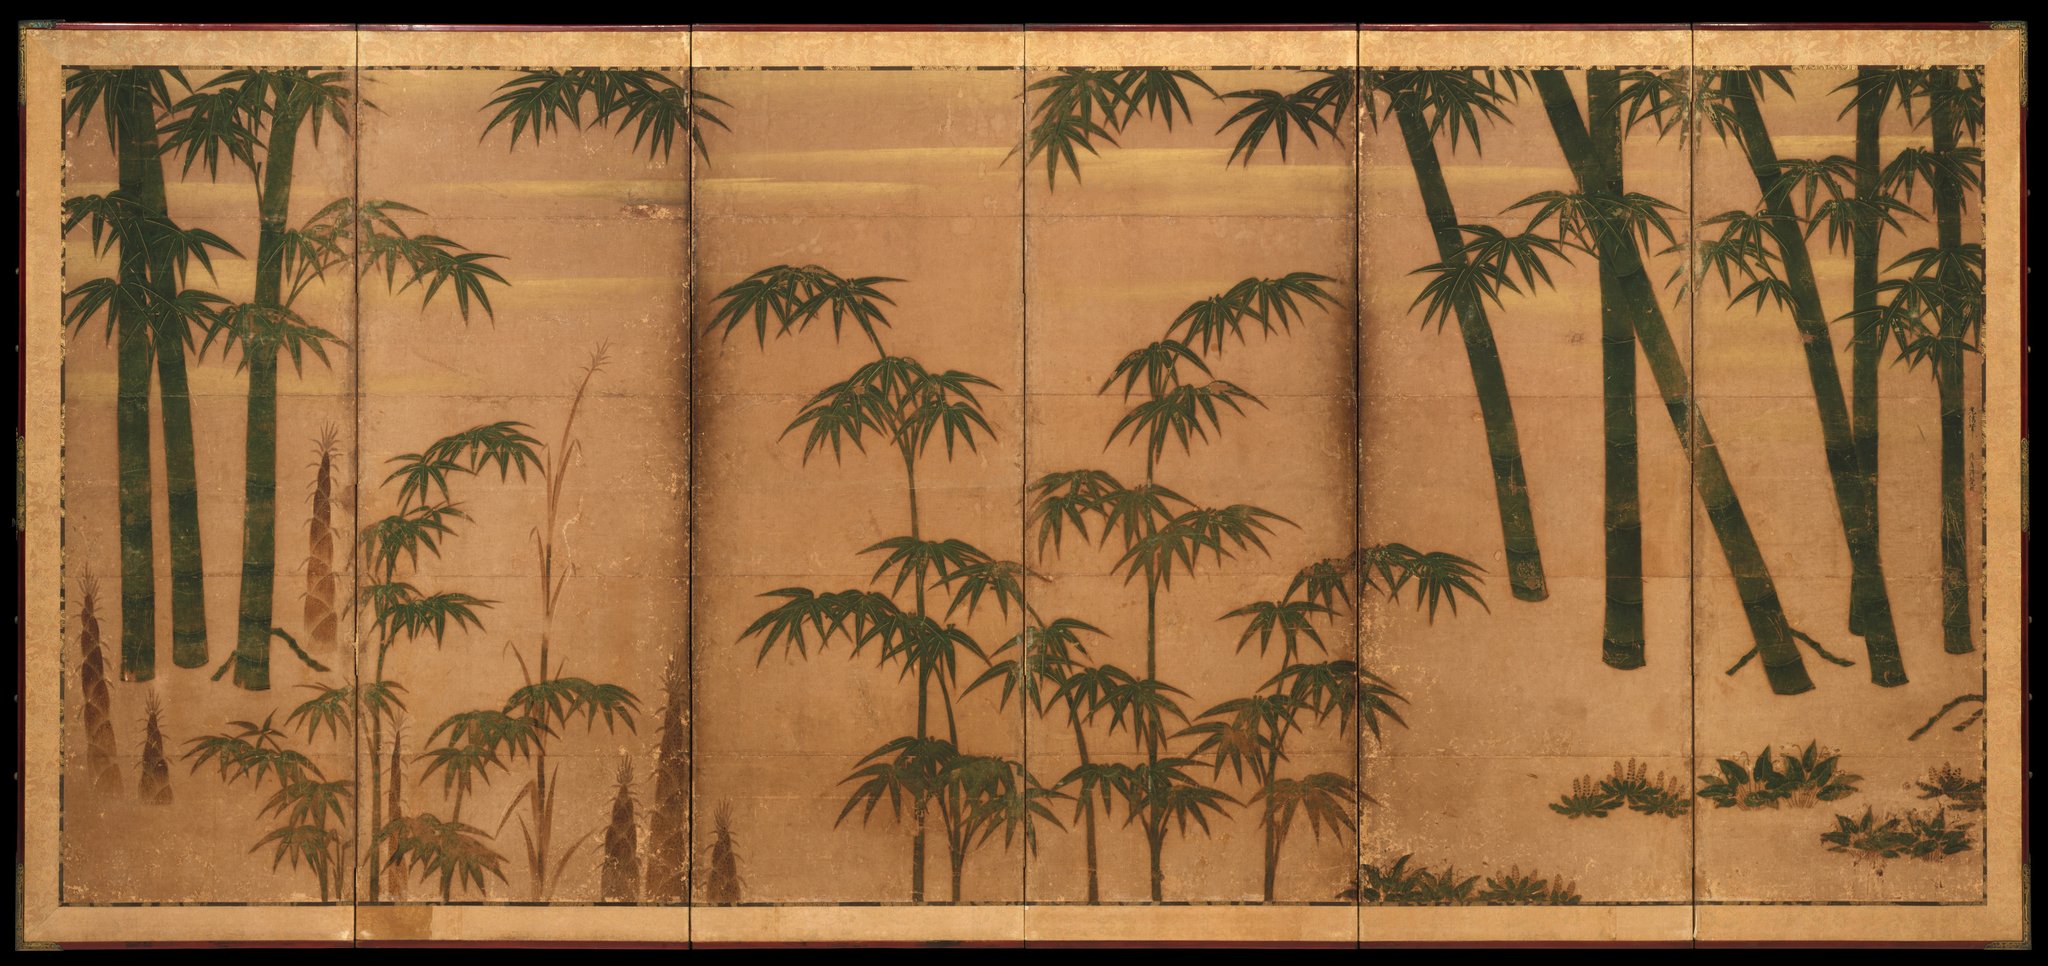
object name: screen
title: Bamboo in the Four Seasons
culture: japanese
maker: tosa mitsunobu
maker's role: artist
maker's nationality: japanese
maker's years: 1462-1525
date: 1467-1533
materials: gold leaf, ink, panel, paper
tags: bamboo